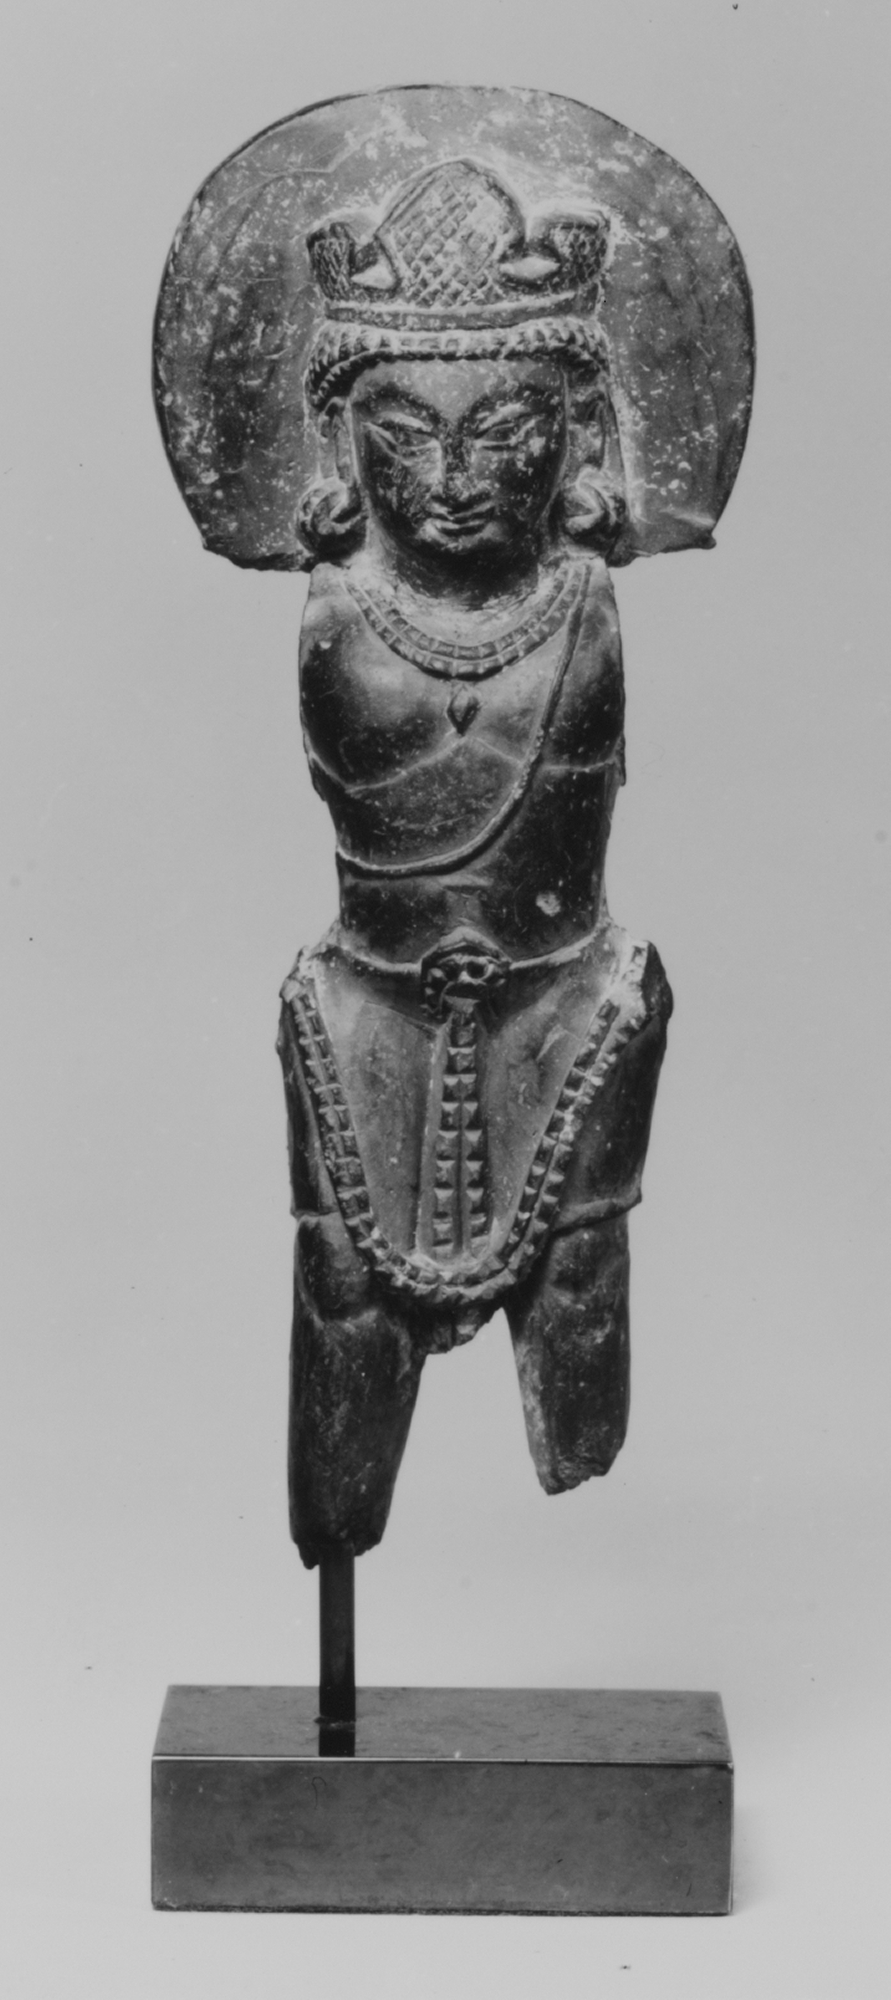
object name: figure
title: Torso of Vishnu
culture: kashmiri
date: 501-600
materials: stone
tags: kashmir,vishnu,hinduism